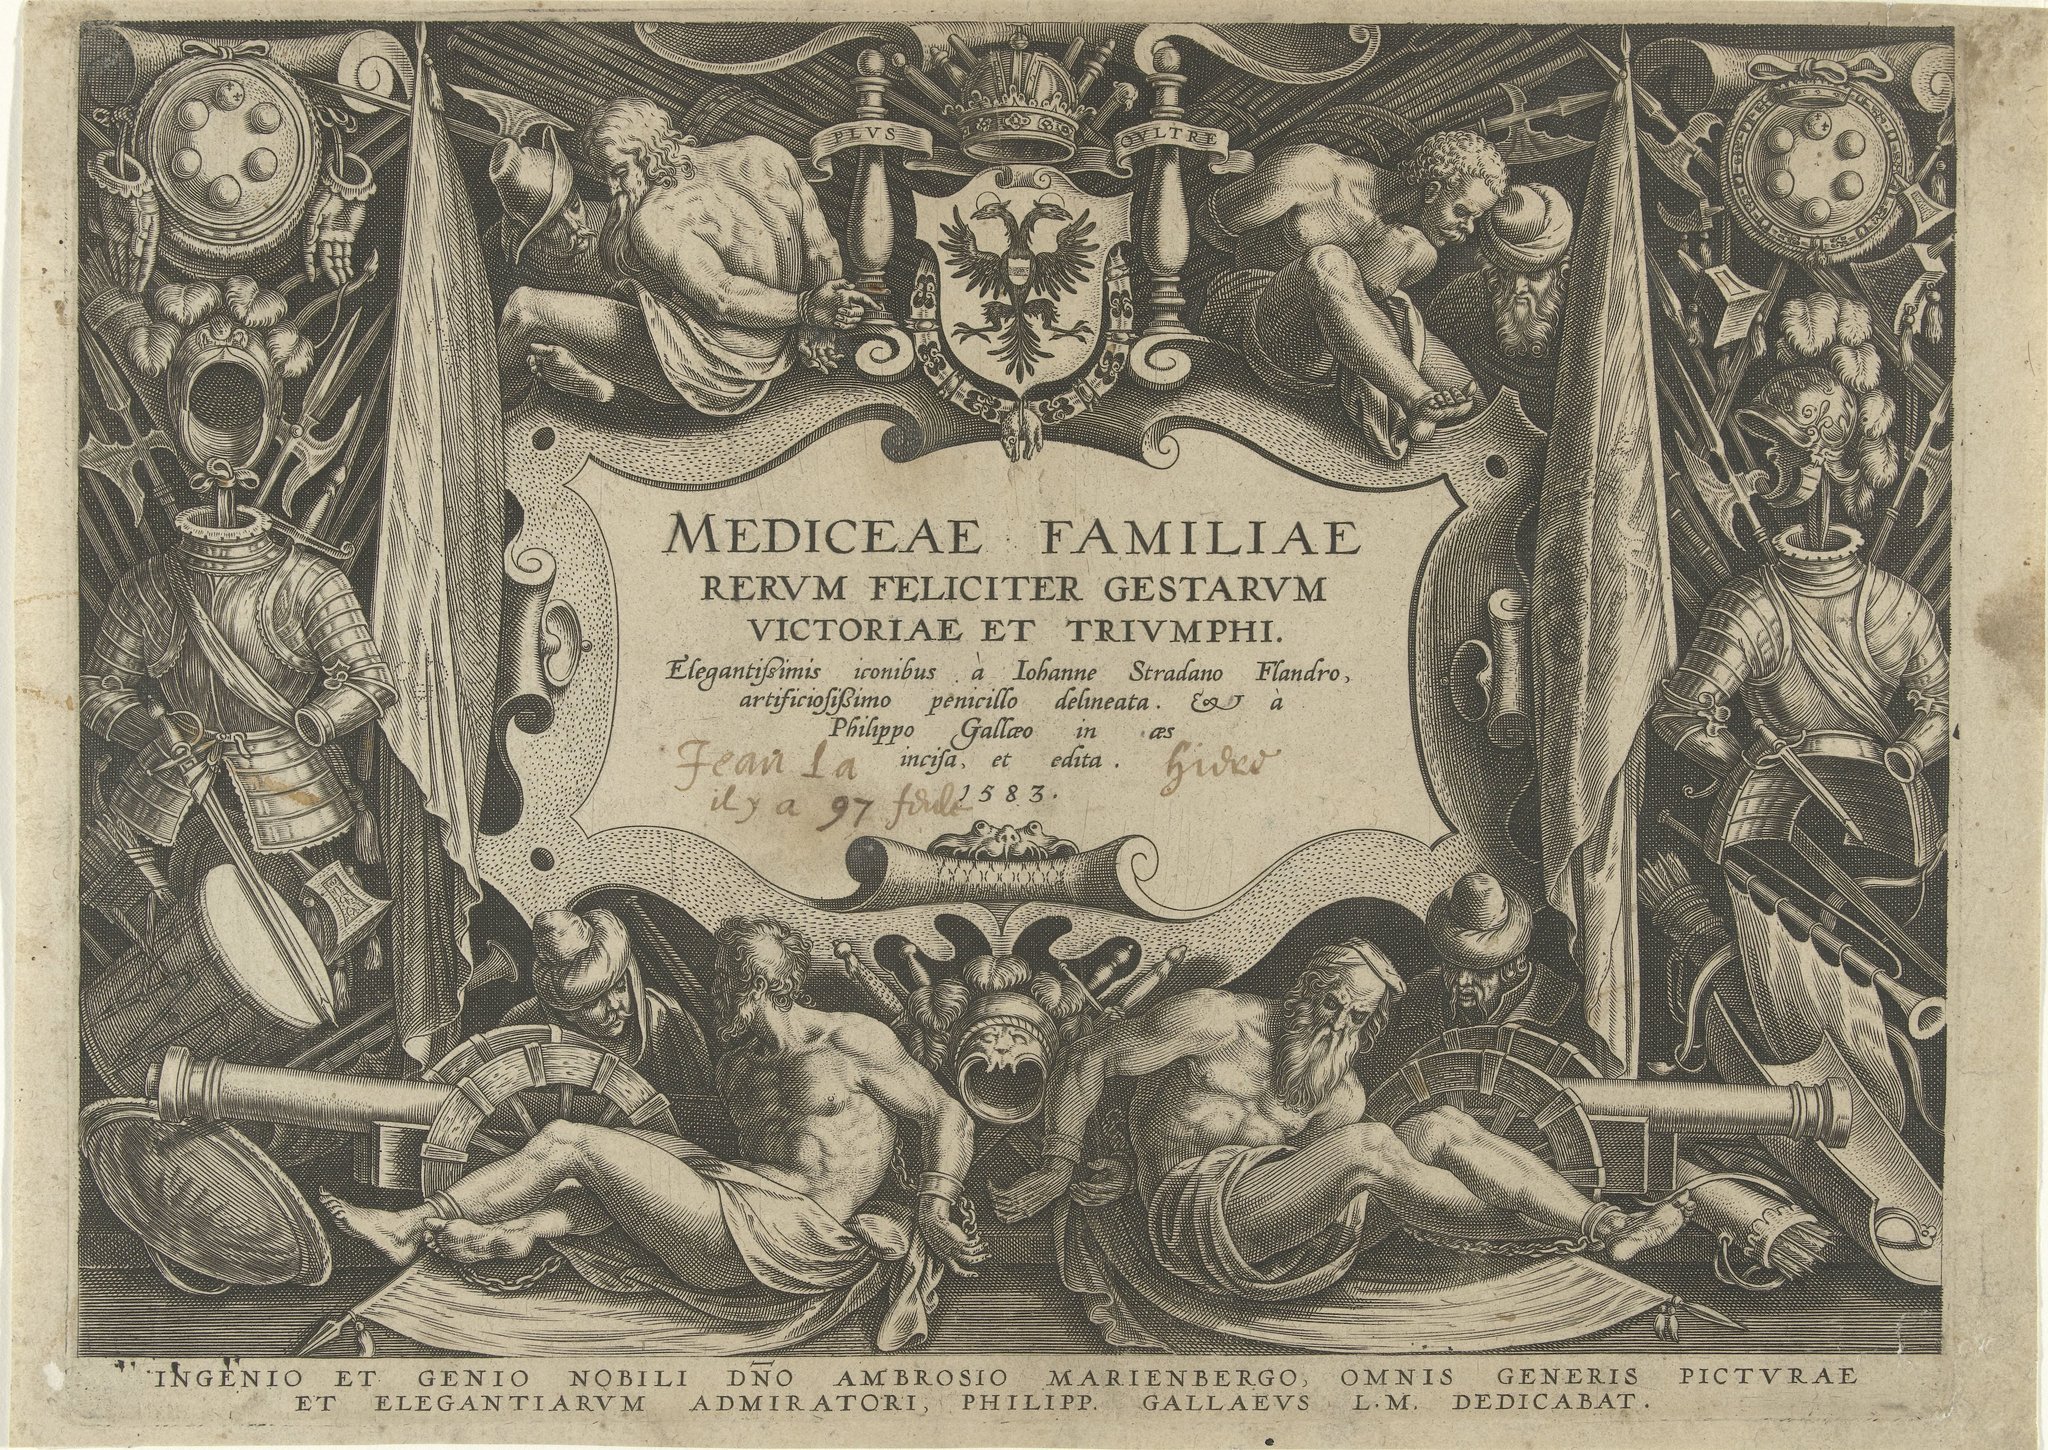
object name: print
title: Titelprent van de serie Mediceae Familiae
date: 1583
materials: paper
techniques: engraving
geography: antwerp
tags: francesco i de' medici, ghent, charles v (holy roman emperor and king of spain), 'tropaion', i.e. decorative ornament ~ weapons, prisoner; in fetters, ornament ~ cartouche, armorial bearing, heraldry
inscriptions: date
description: In een cartouche de titel van de prent. Rondom de cartouche allerlei wapentuig en enkele gevangenen. Links en rechts van de cartouche het wapen van het geslacht De' Medici. Titelprent van een prentenserie over de familiegeschiedenis van het geslacht De' Medici